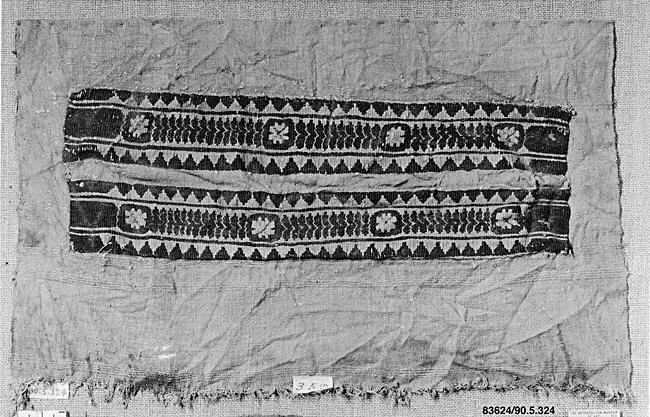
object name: textile fragment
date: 201-400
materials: linen, wool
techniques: weave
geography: egypt